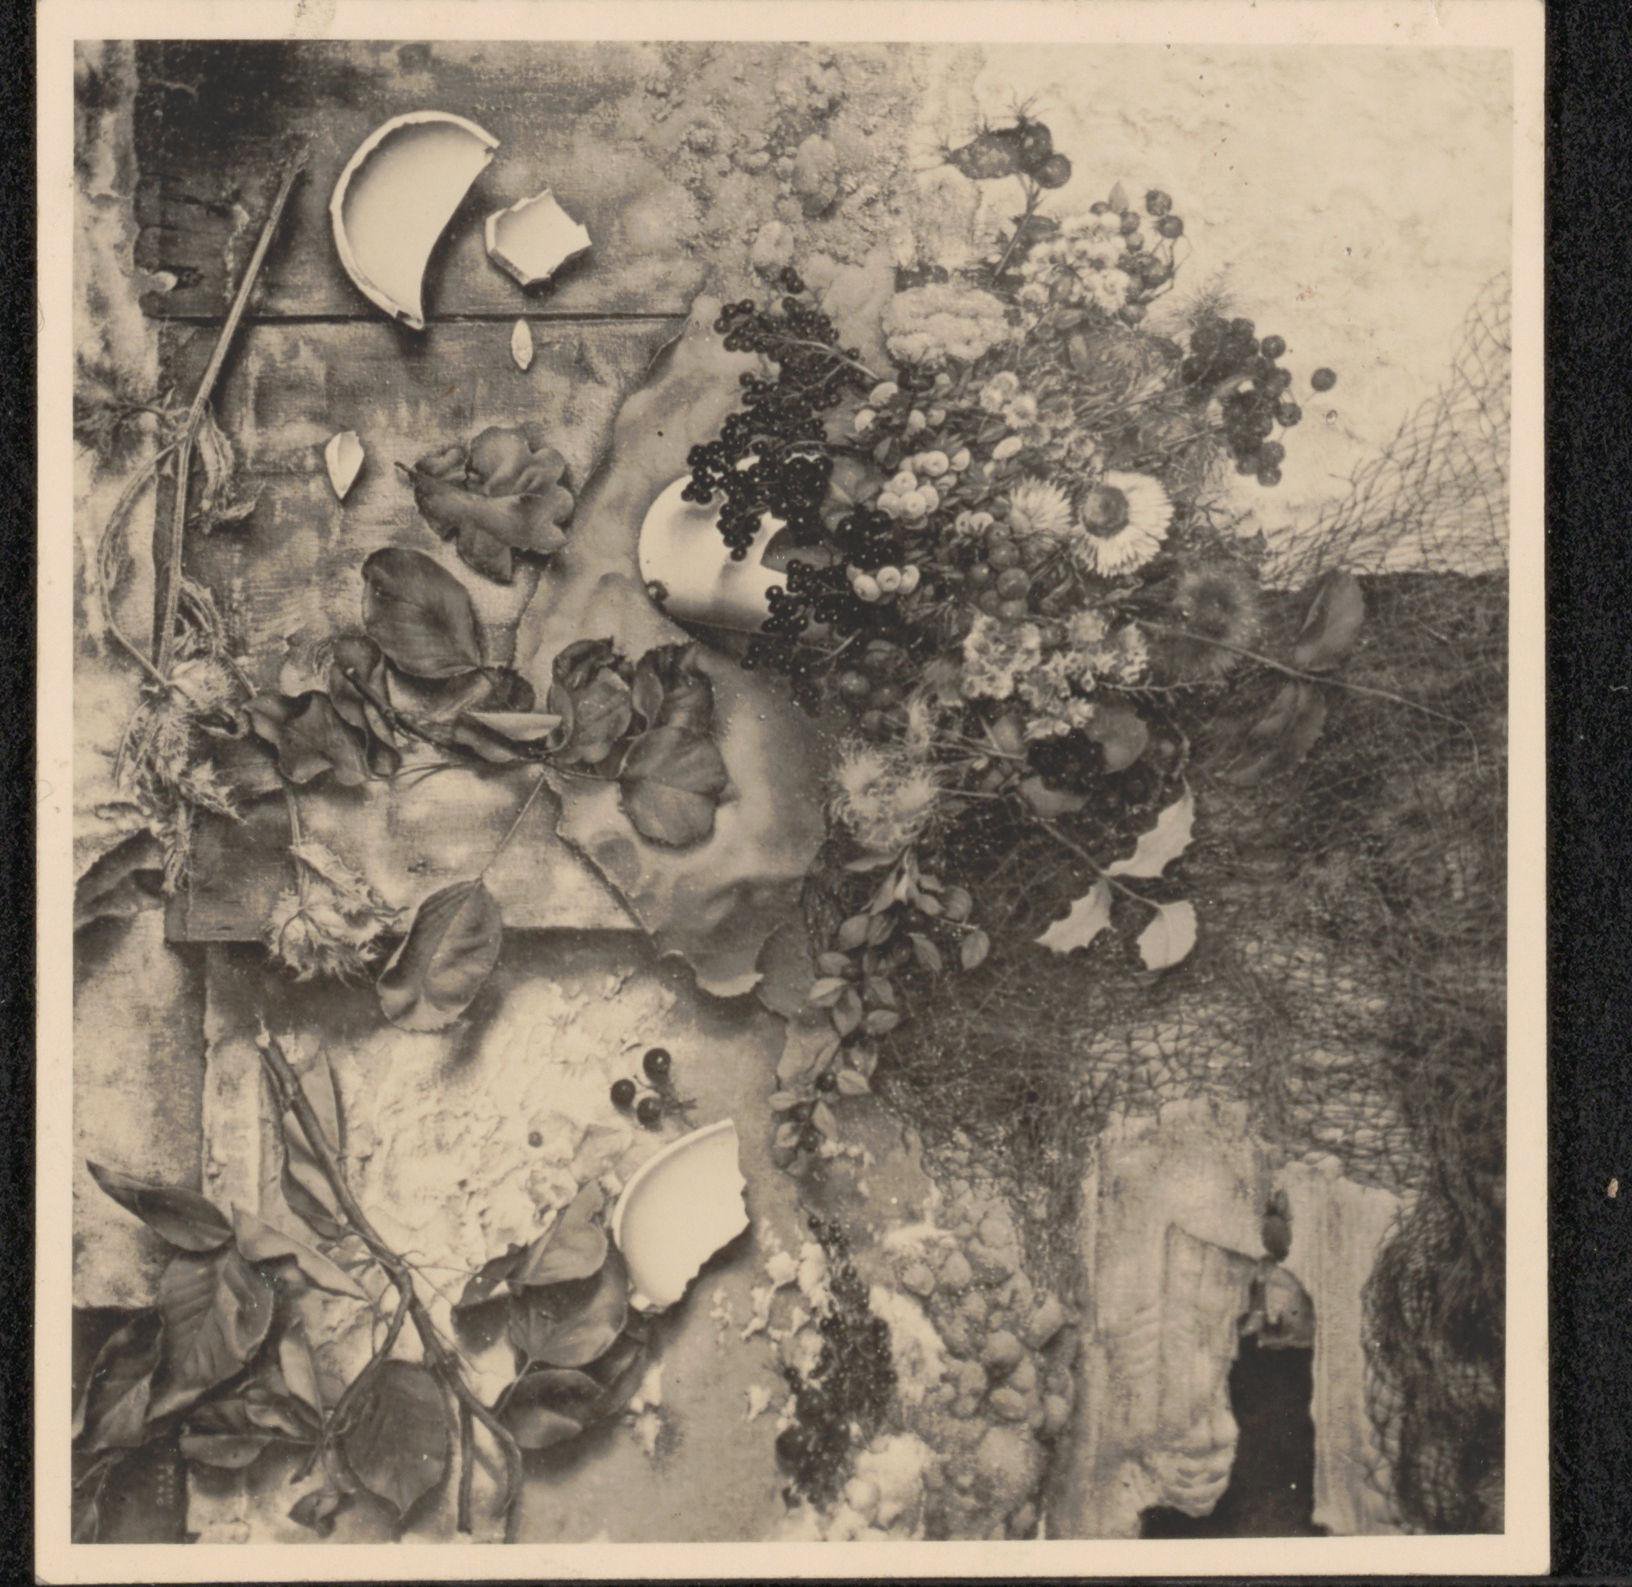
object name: reproduction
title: Fotoreproductie van een geschilderd stilleven van Dick Ket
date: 1933-1986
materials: photographic support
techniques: gelatin silver print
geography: arnhem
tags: den helder, print maker, draughtsman, dick ket, cut flowers; nosegay, bunch of flowers